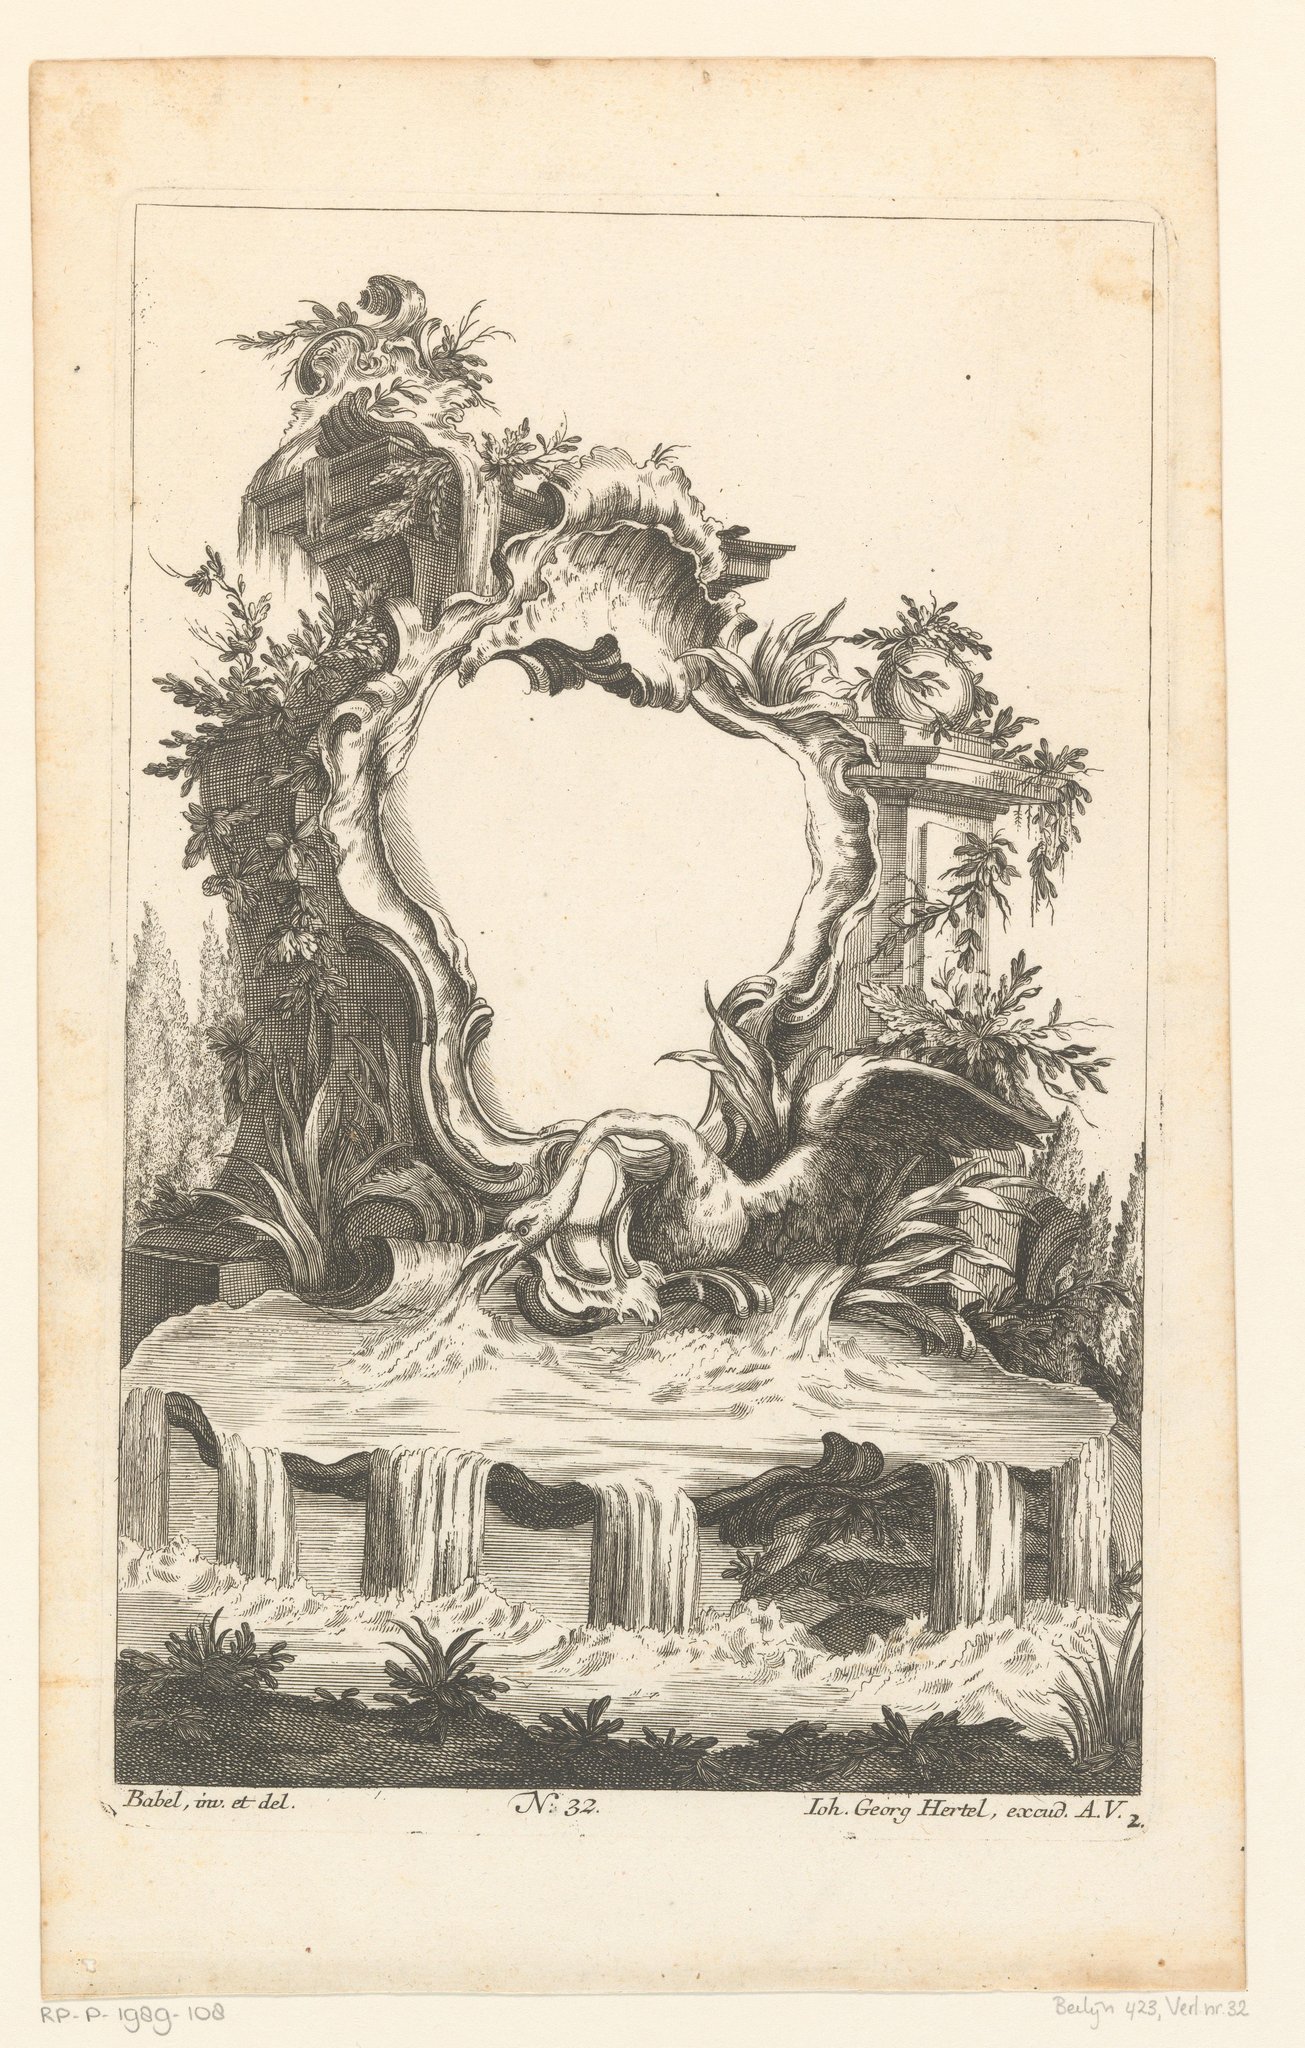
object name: ornament print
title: Cartouchevormige fonteinen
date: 1730-1775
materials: paper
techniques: engraving, etching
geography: augsburg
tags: water-birds: swan, garden fountain, ornament ~ cartouche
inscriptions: collector's mark: Lugt 2228, collector's mark: Lugt 2760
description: Een rocaille cartouchevormige fontein met een zwaan. Uitgeversnummer 32.